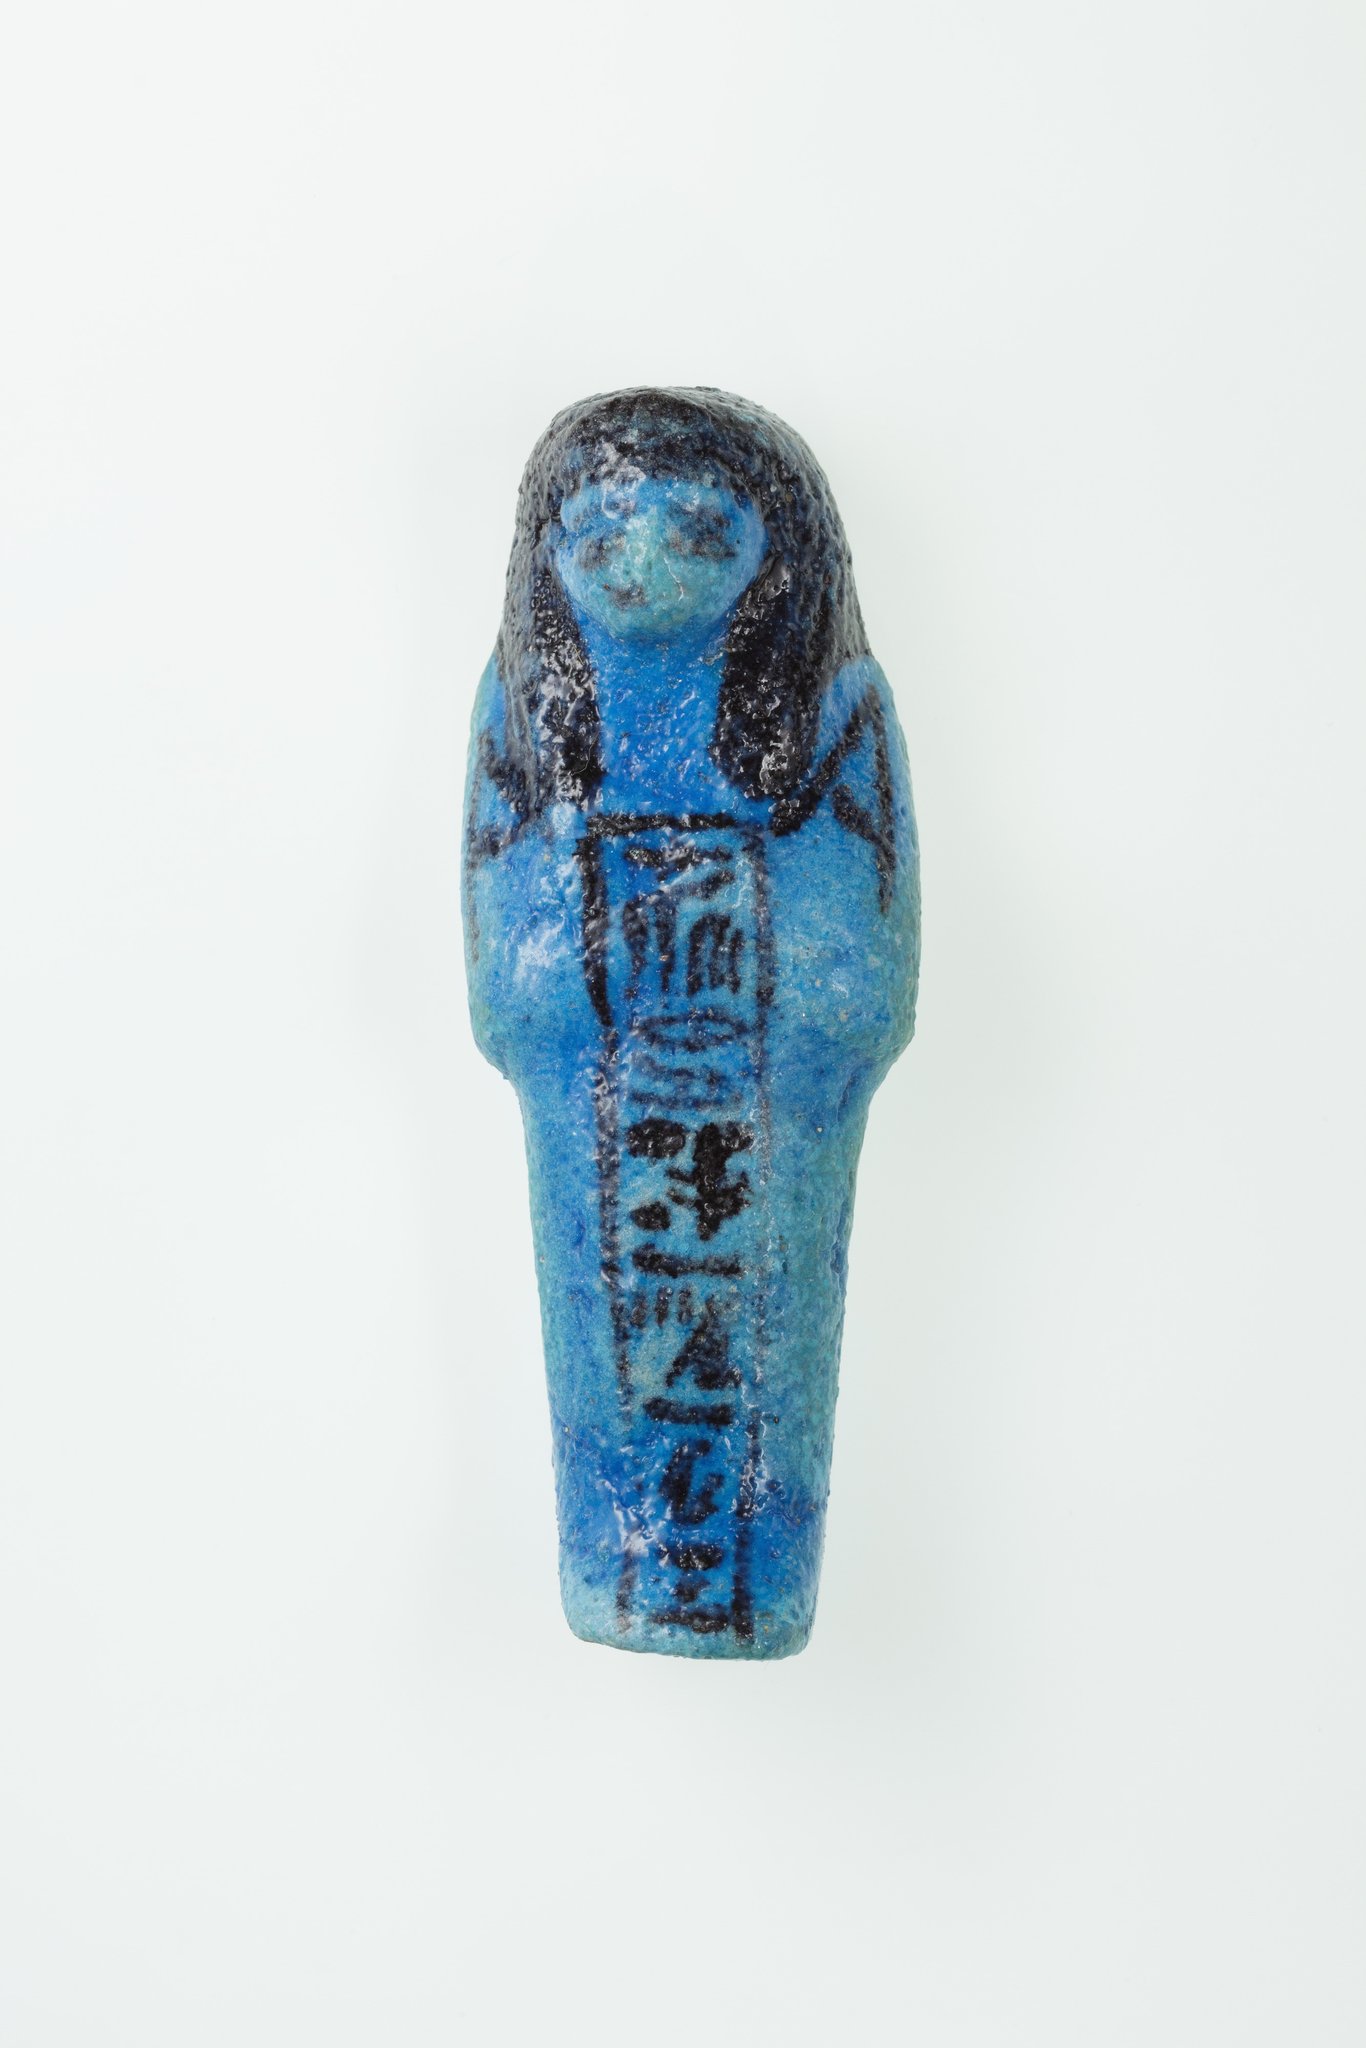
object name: shabti, worker, nauny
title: Worker Shabti of Nauny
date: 1050 BCE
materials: faience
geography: egypt